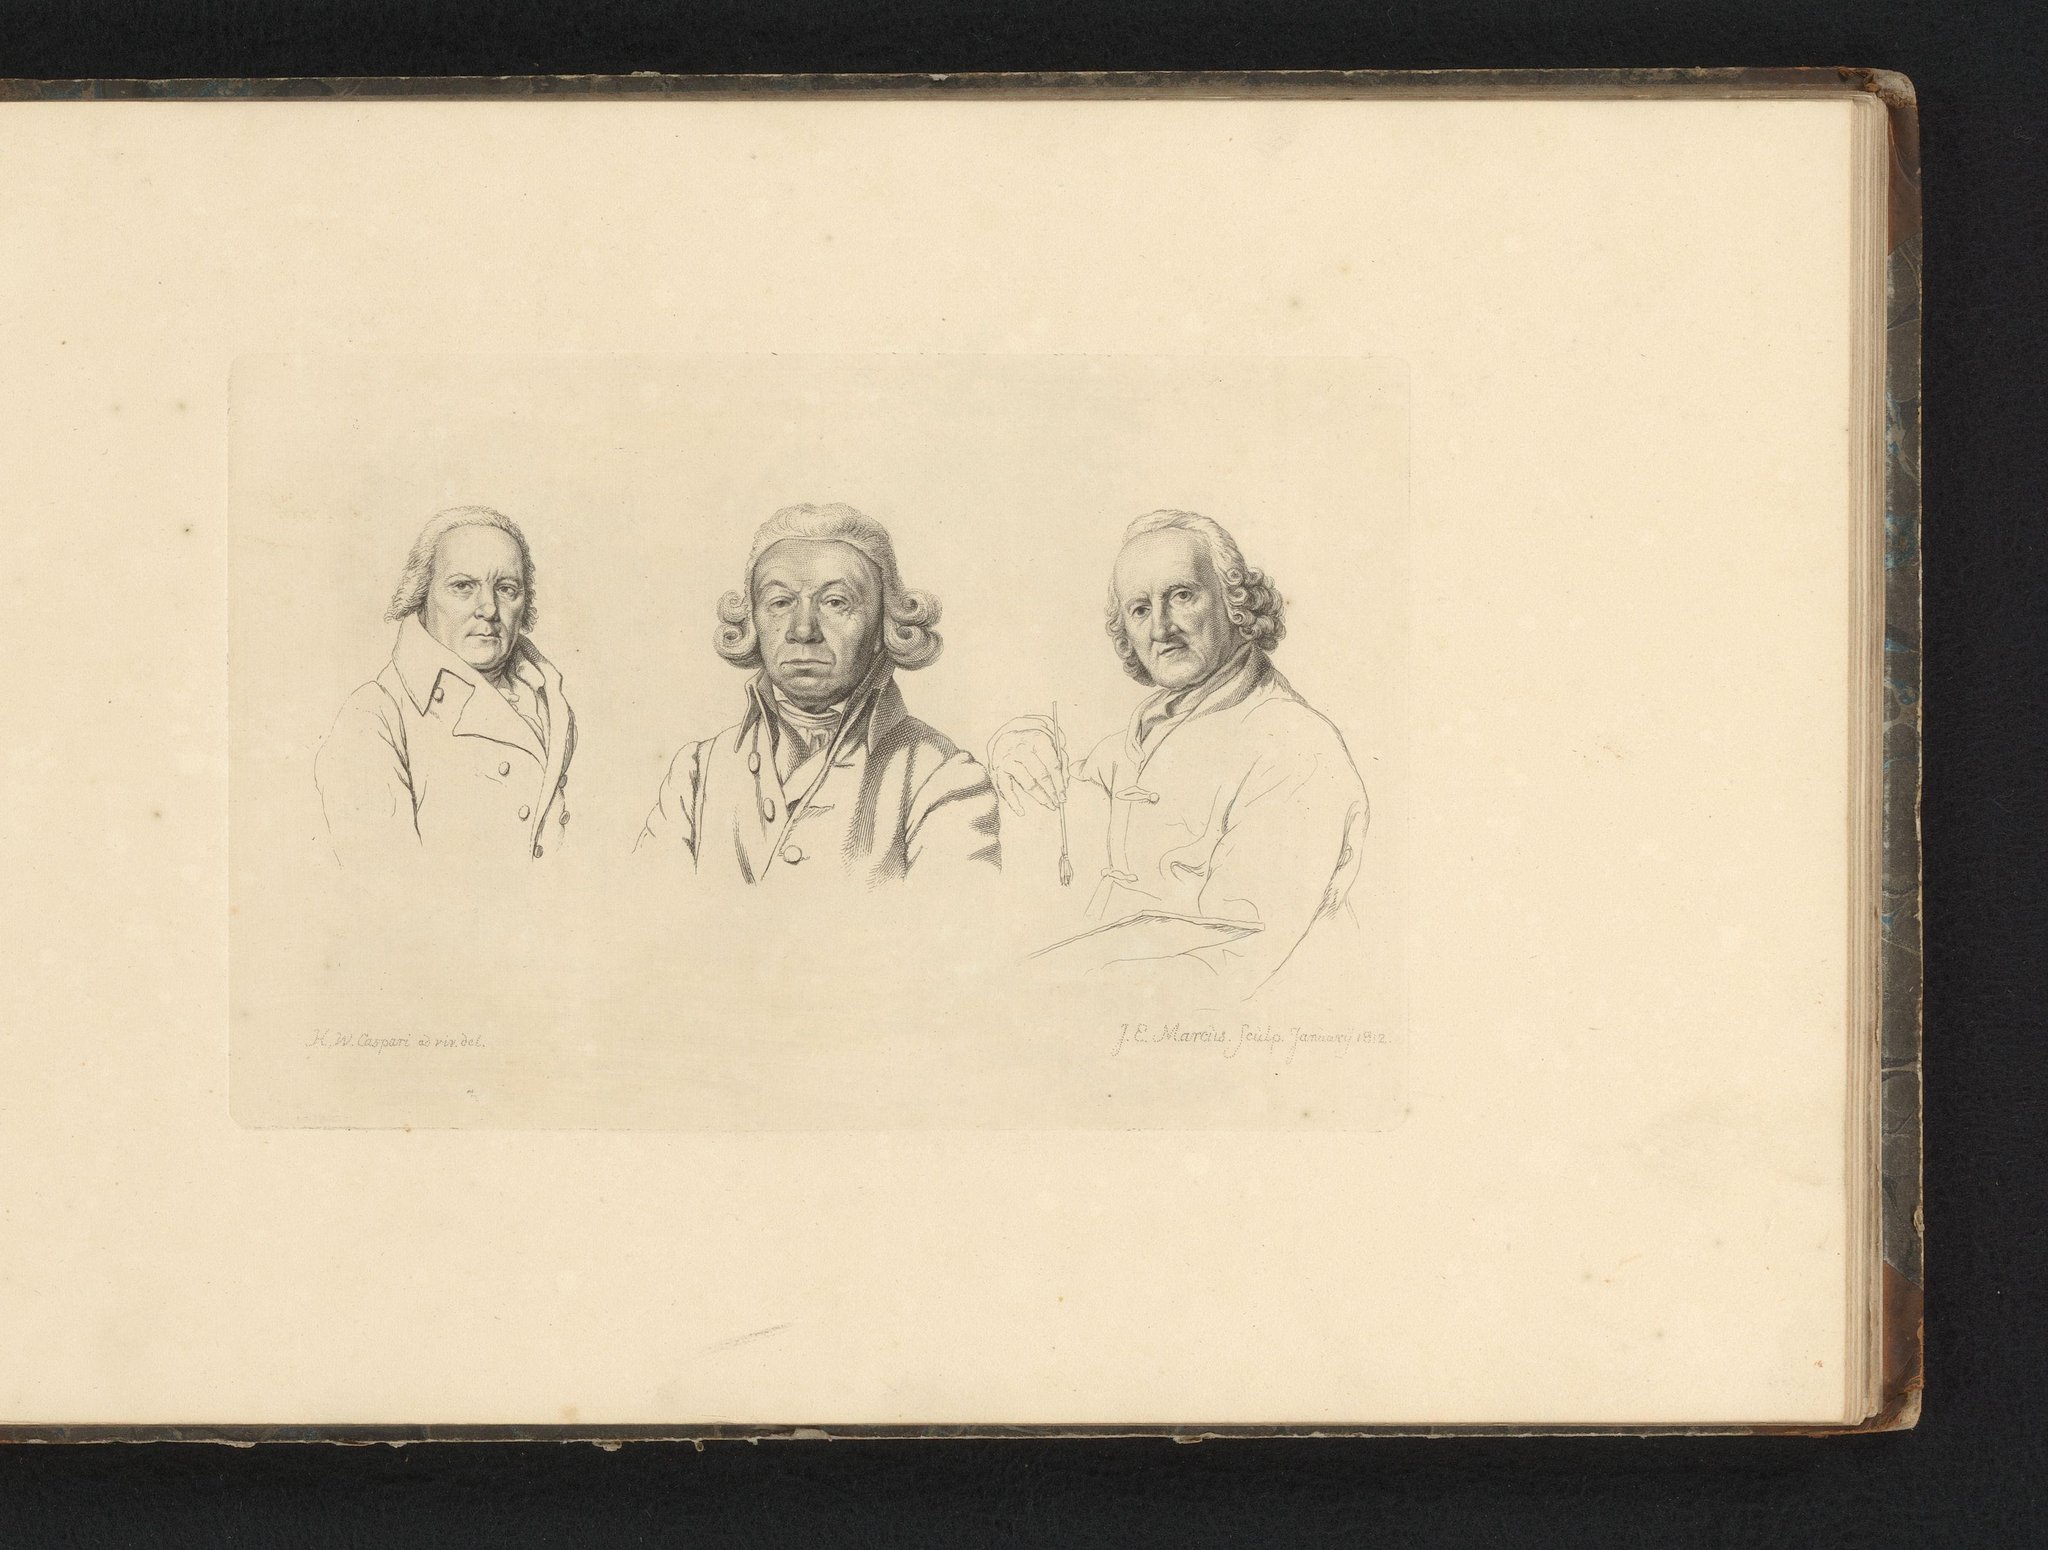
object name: album leaf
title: Portretten van Jacobus Buys, Izaak Schmidt en Jurriaan Andriessen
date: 1801-1812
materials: paper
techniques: etching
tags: painter, jurriaan andriessen, amsterdam, print maker, draughtsman, izaak schmidt, jacobus buys, portrait, self-portrait of artist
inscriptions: date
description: Deze prent maakt deel uit van een album.